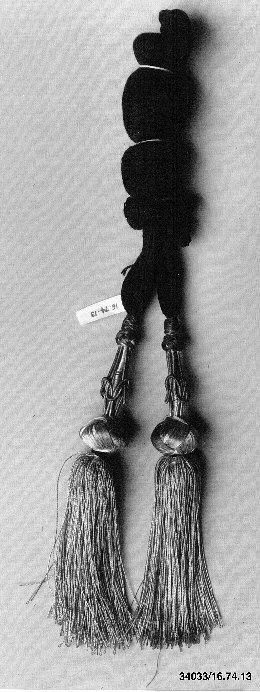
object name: tassel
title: Tassels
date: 1867-1900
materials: silk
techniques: gilding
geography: iran